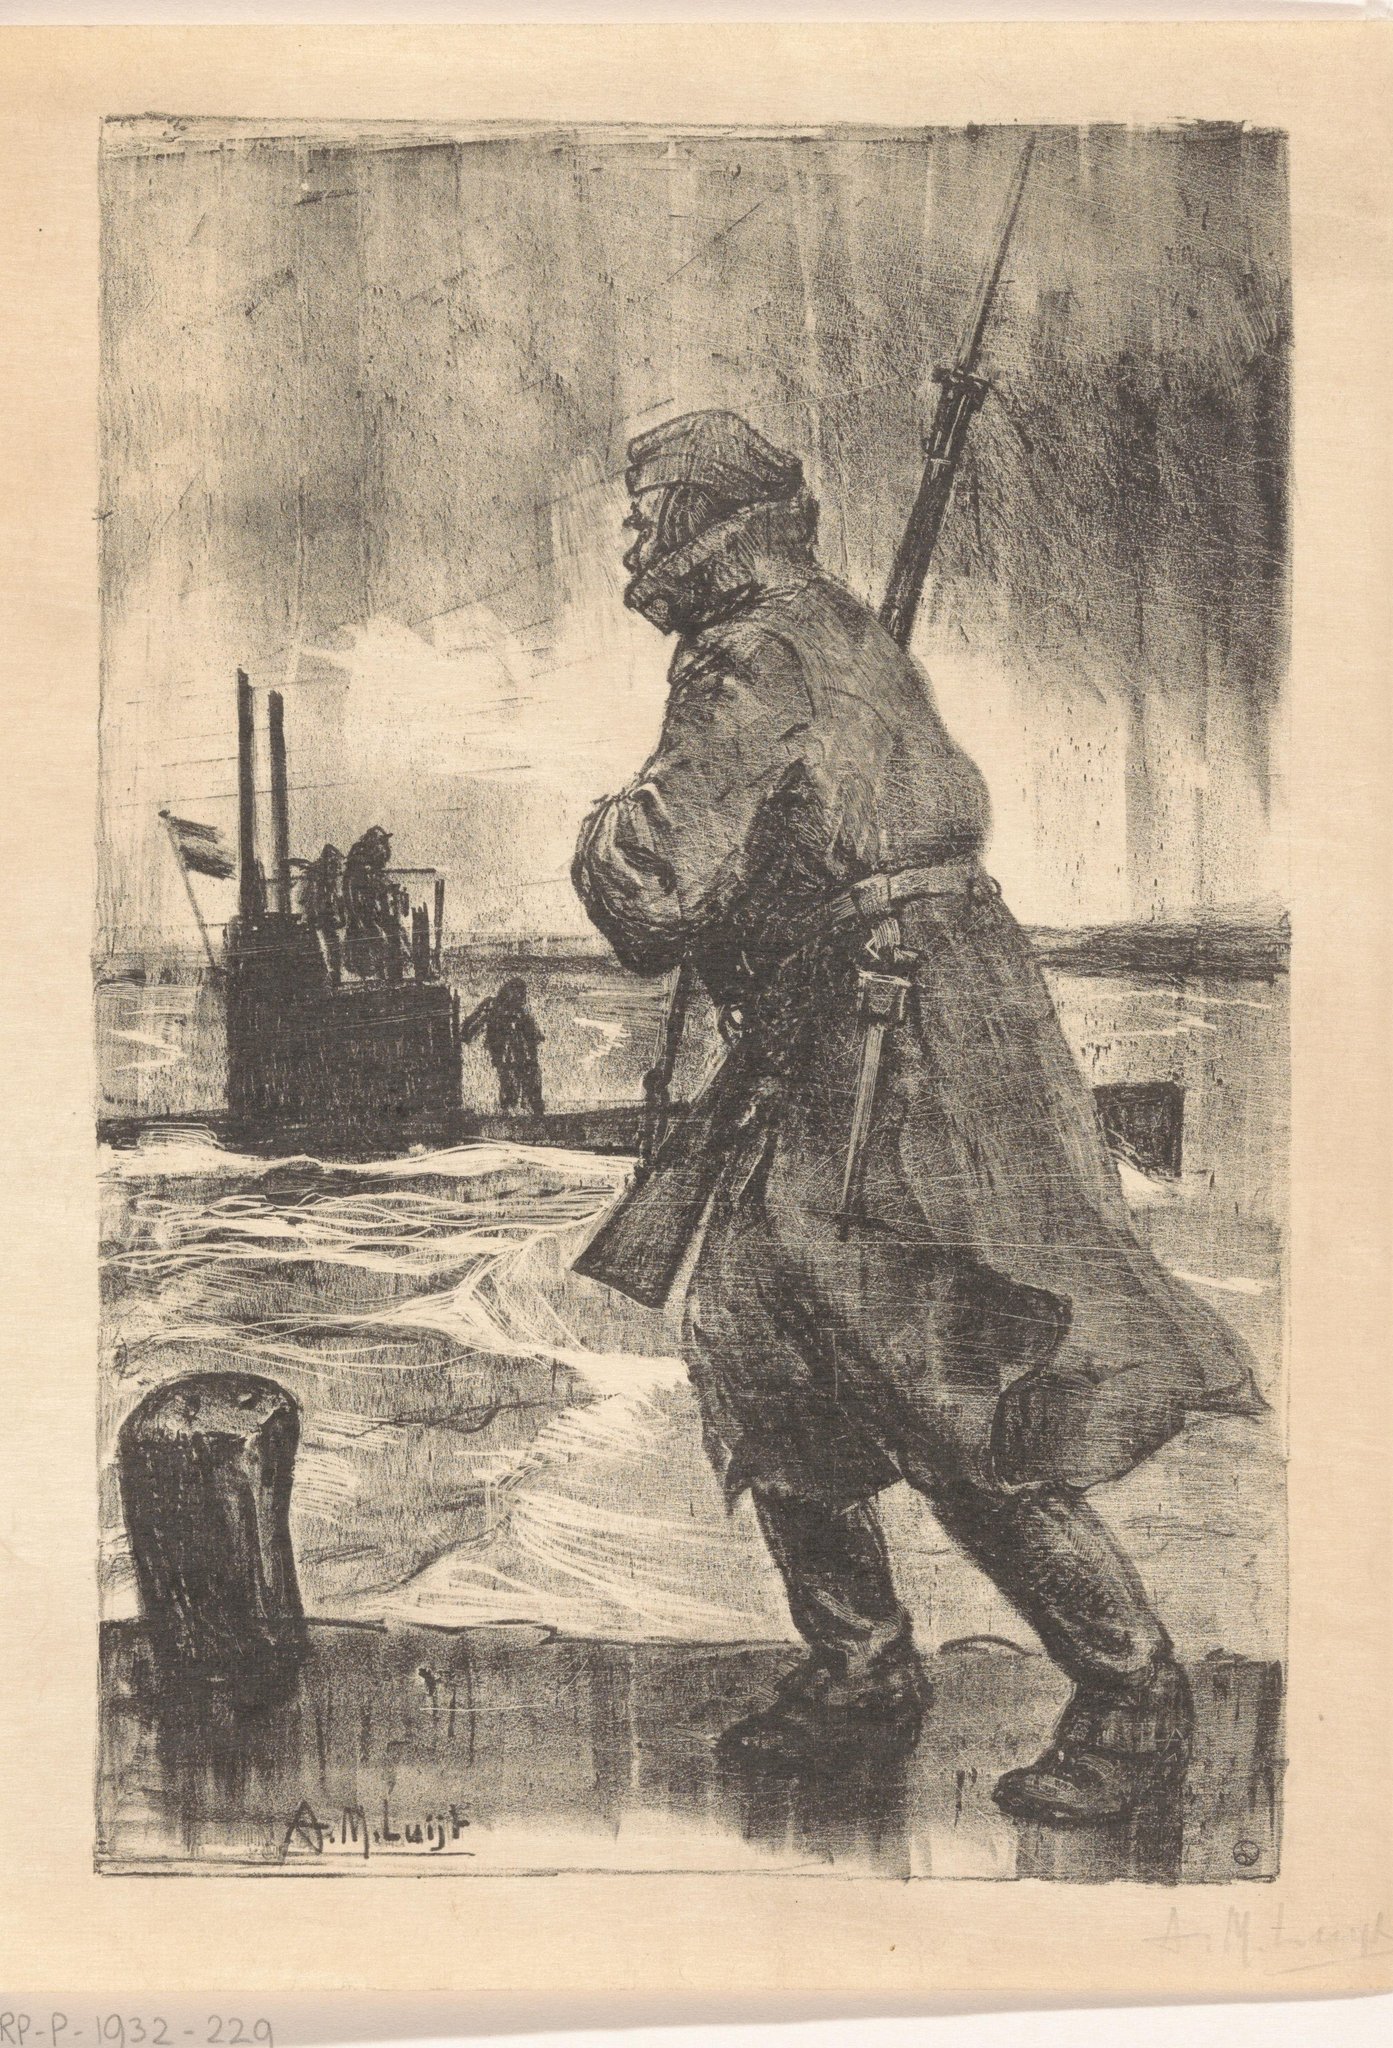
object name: print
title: Kustwacht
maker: arie martinus luijt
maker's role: print maker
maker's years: 1879-1951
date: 1889-1932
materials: paper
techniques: lithograph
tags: submarine, guard duty, keeping sentry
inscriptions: collector's mark: Lugt 2228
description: Een soldaat in een lange jas met een geweer onder de arm loopt over de kade. Achter hem steekt een onderzeeër boven het water uit.